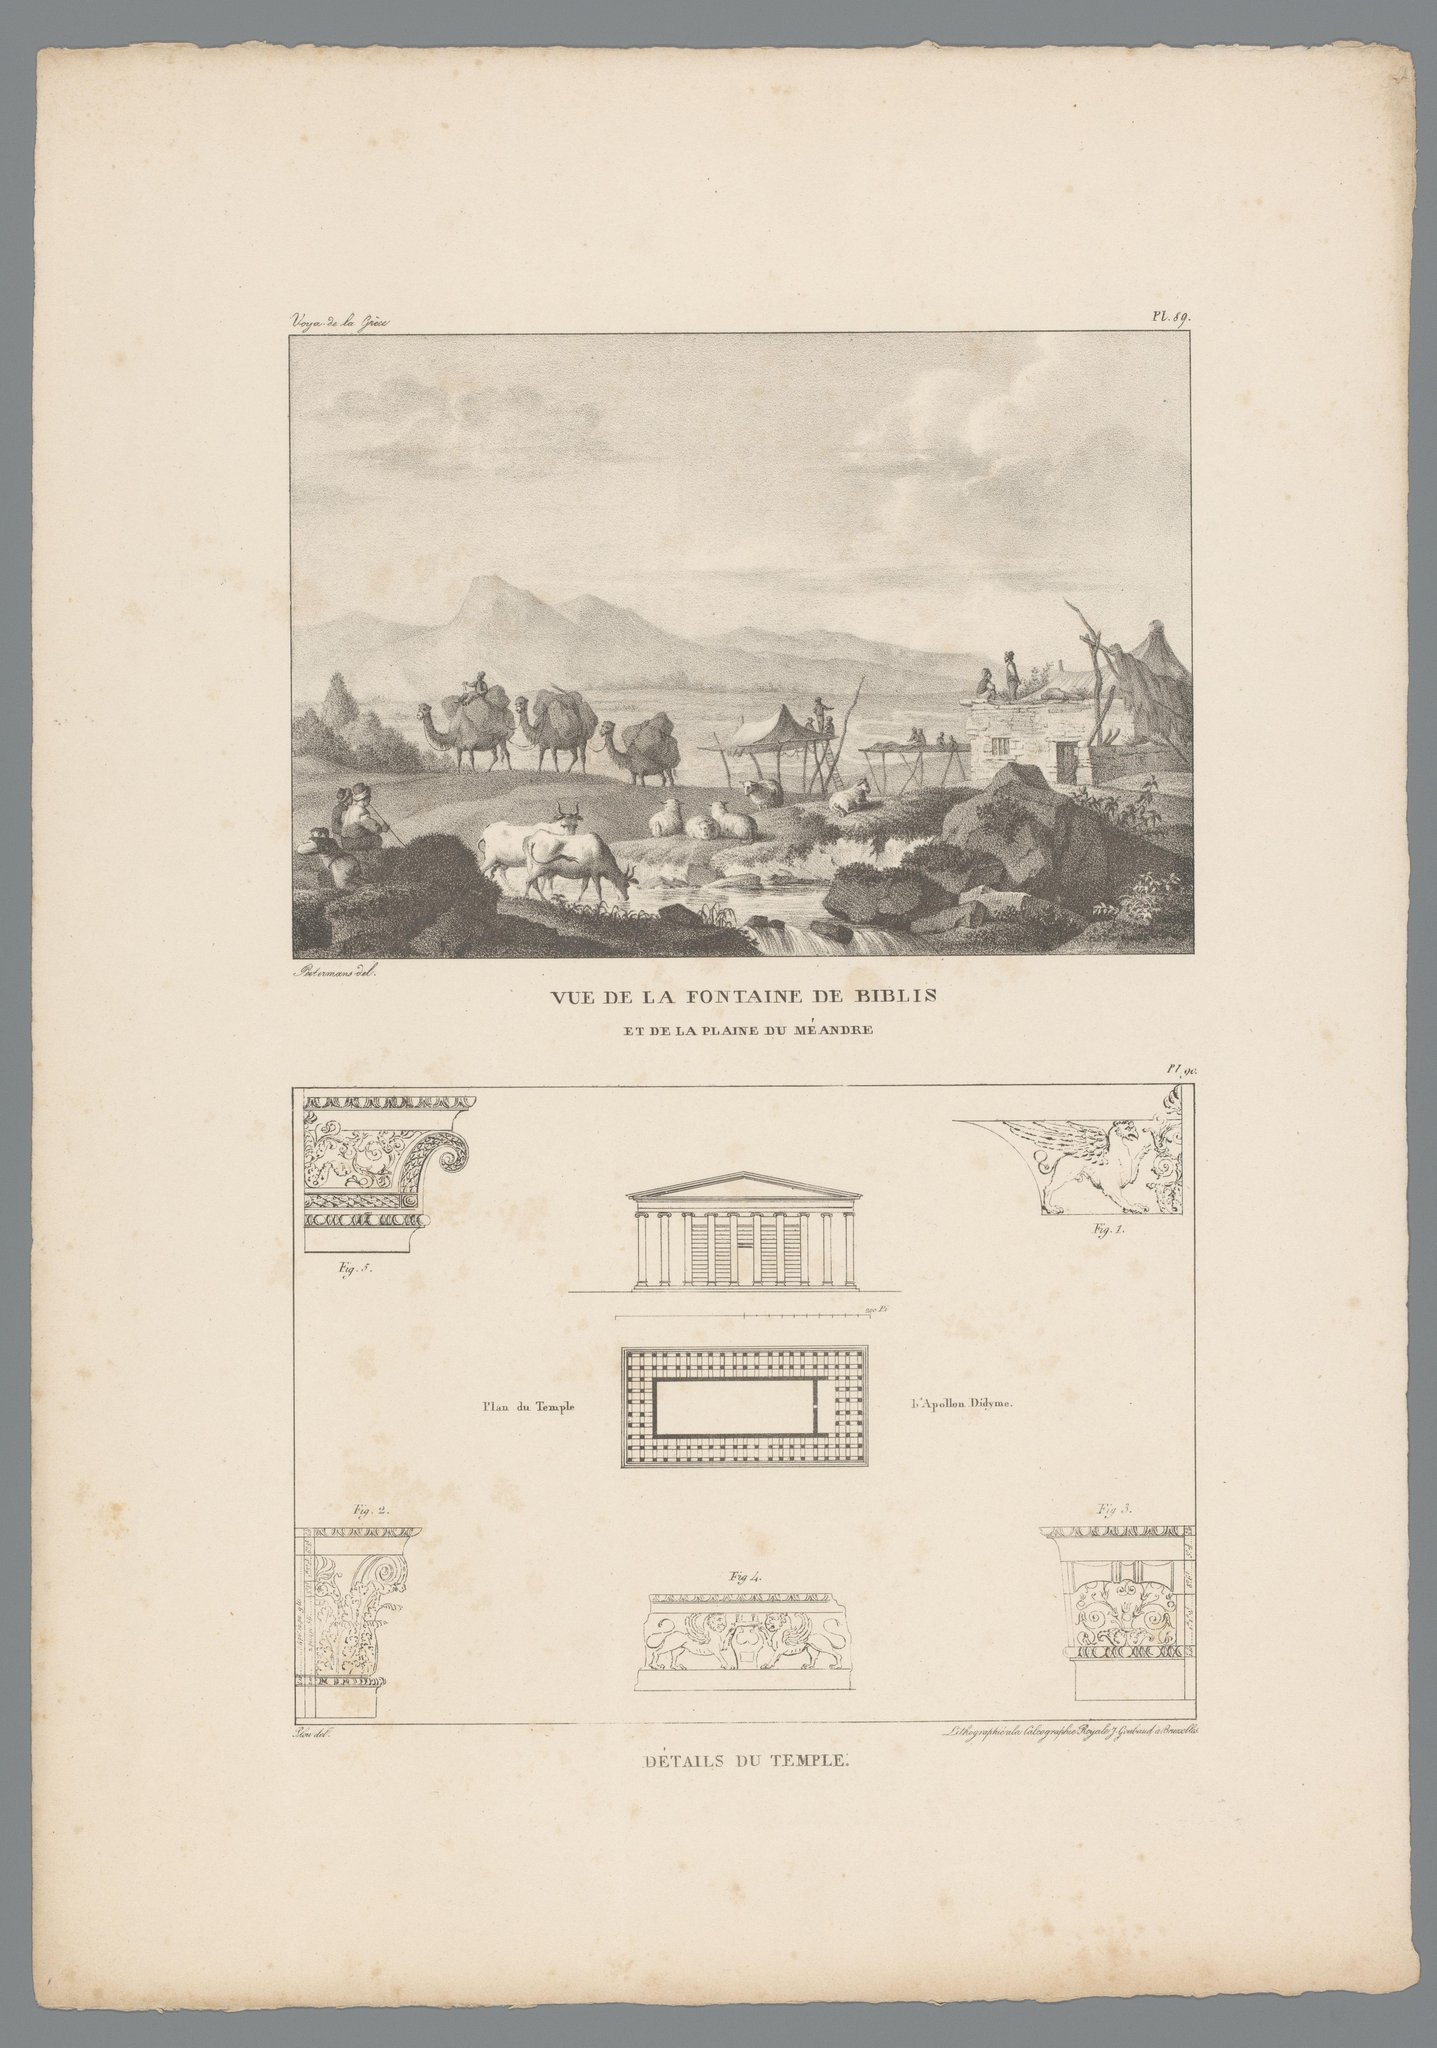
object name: print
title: Détails du temple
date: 1822-1825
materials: paper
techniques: lithograph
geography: brussels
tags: landscapes, herd, flock, temple, shrine ~ greek religion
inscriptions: collector's mark: Lugt 2228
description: Prent waarschijnlijk verschenen in: Choiseul-Gouffier, Marie-Gabriel-Auguste-Florent. Voyage pittoresque de la Grèce. Parijs: s.n., 1822-1825.